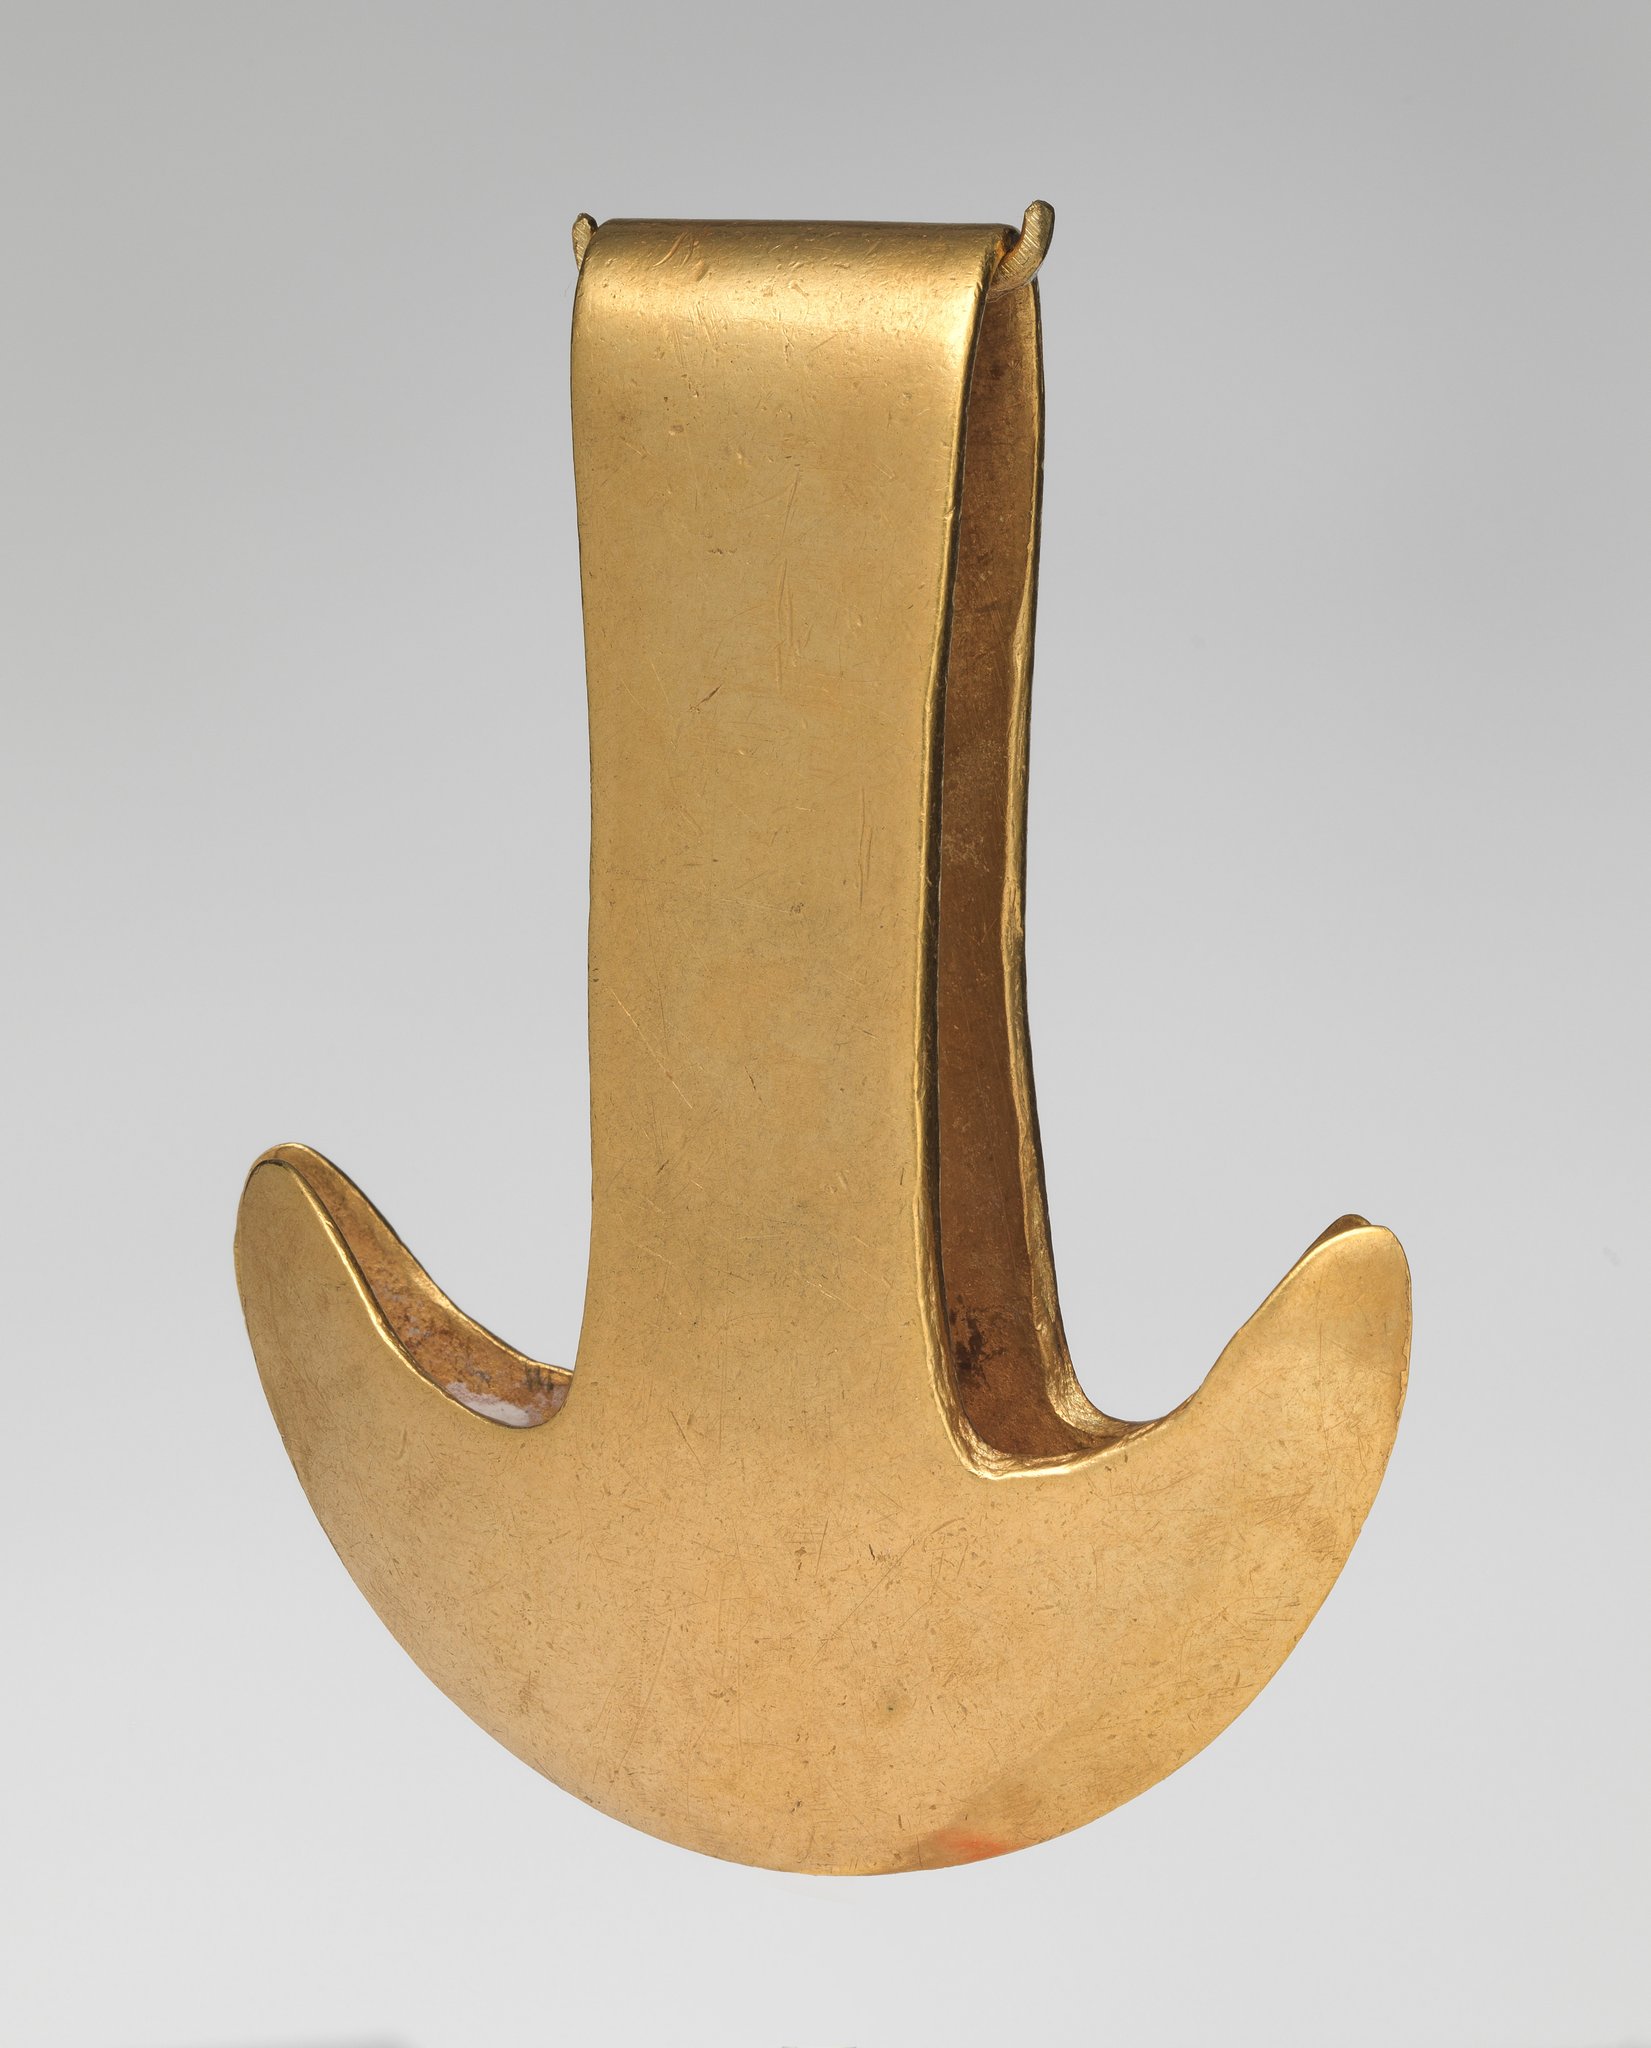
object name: tweezer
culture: calima or yotoco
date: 1-700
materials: gold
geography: colombia